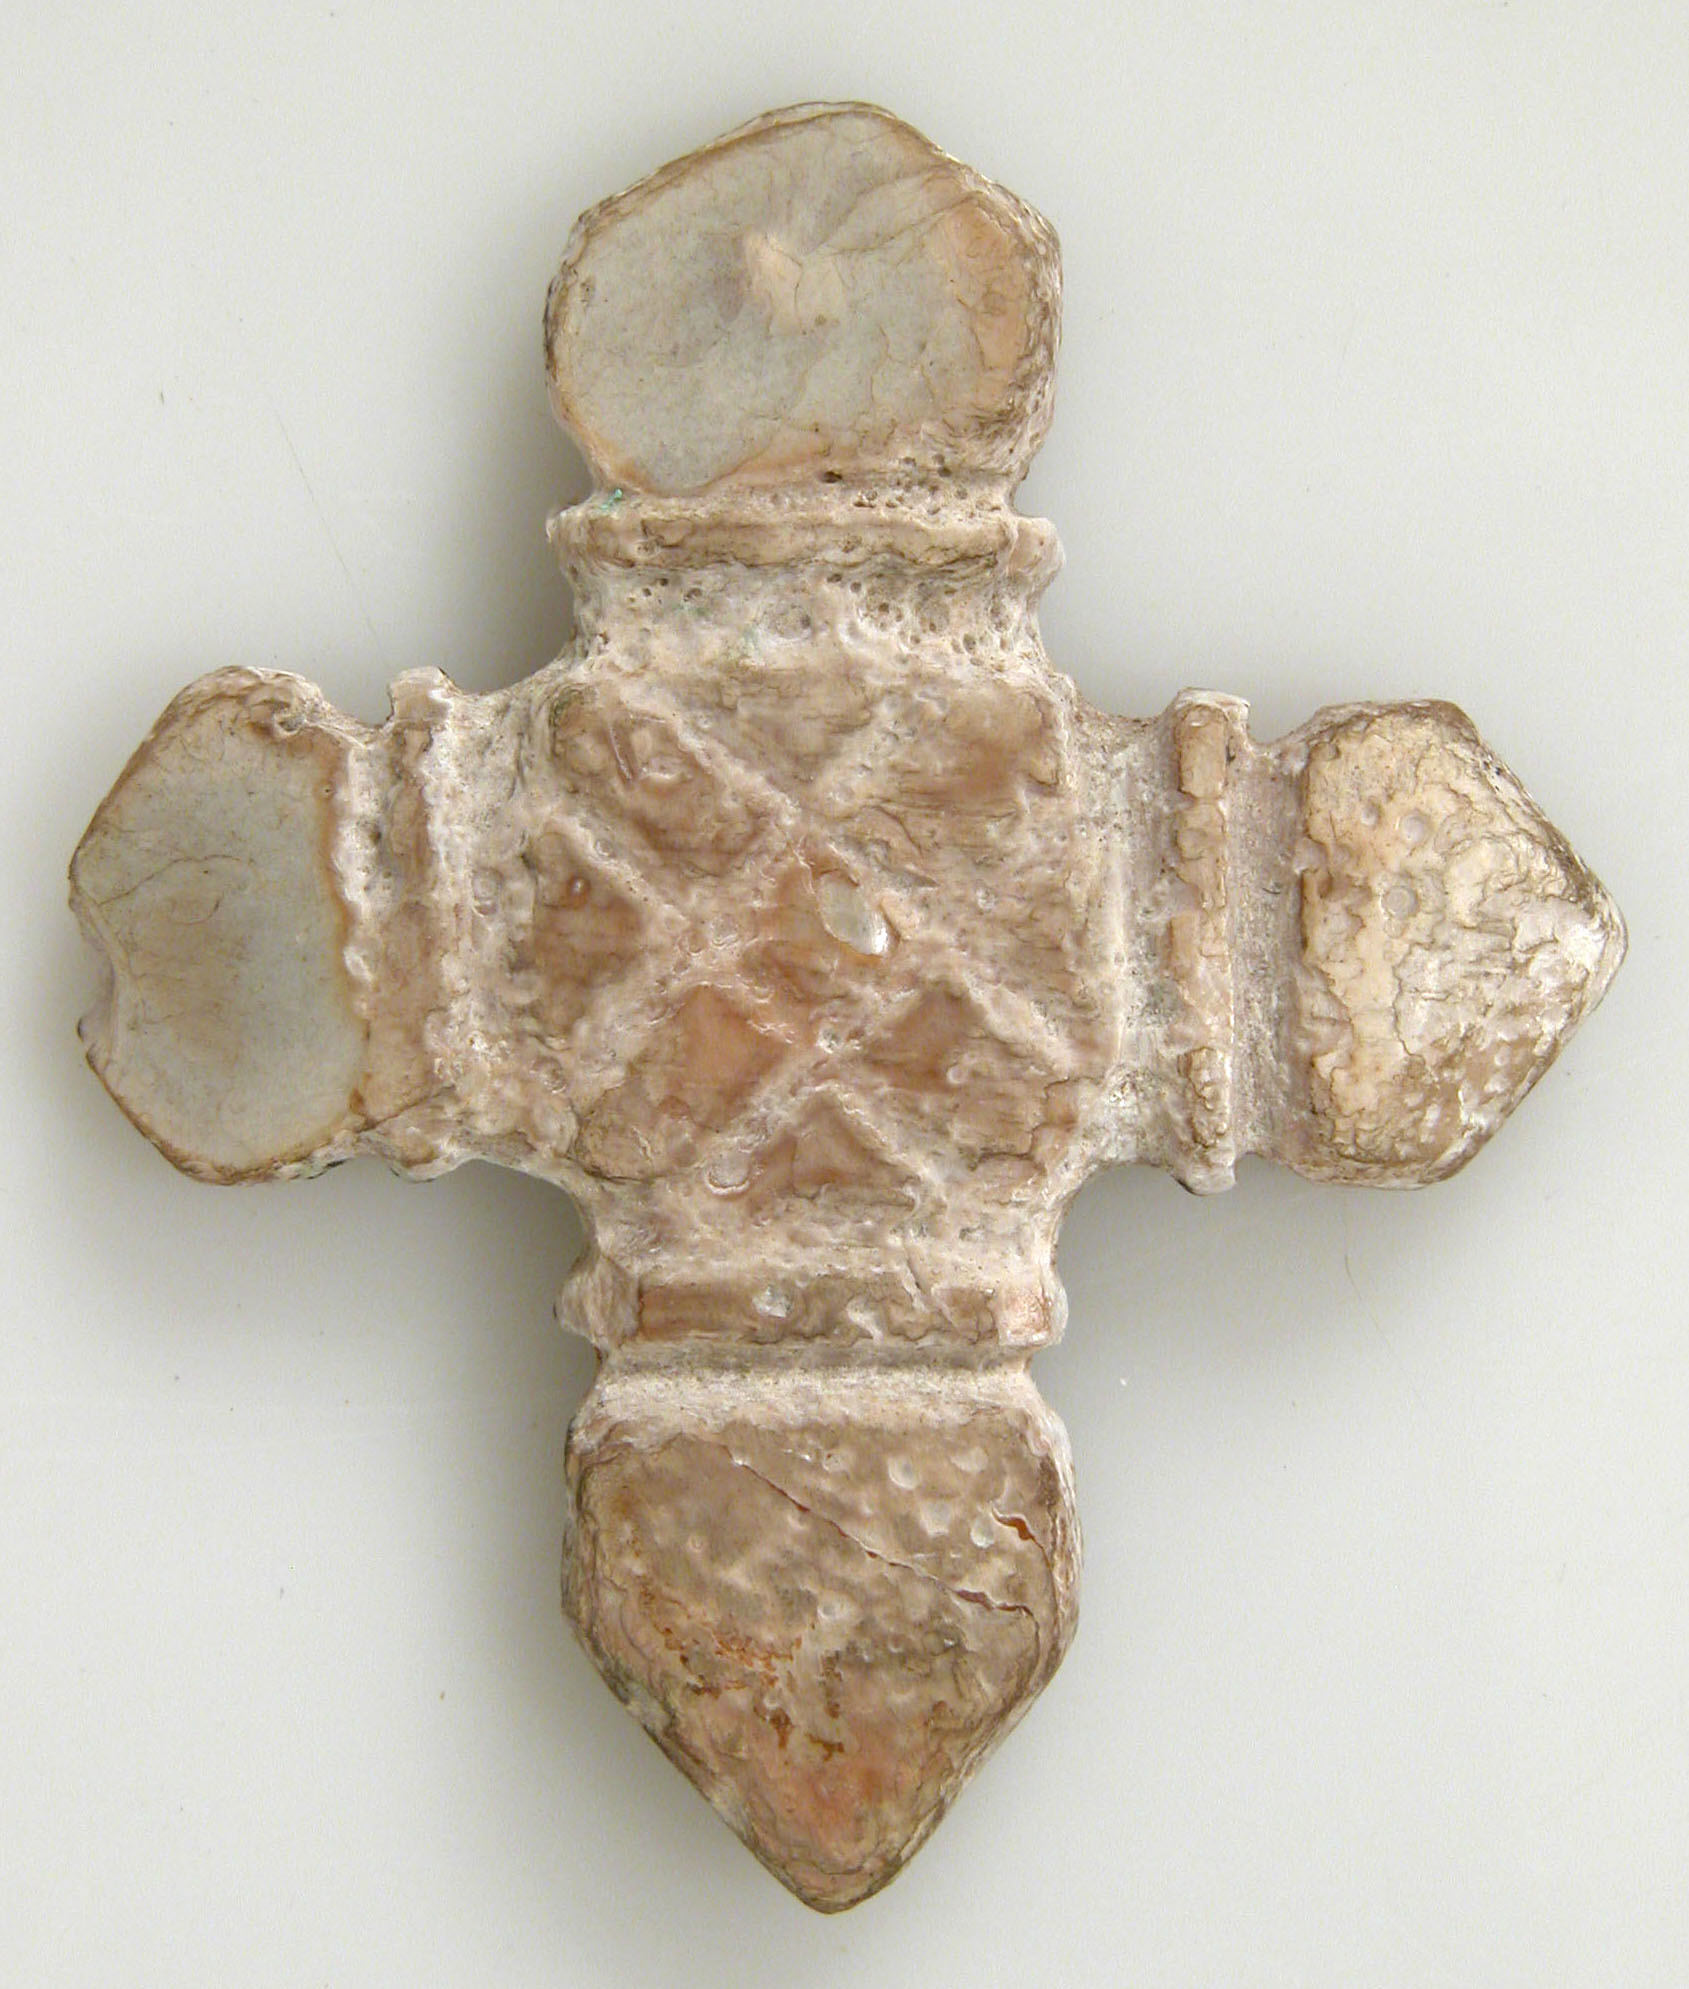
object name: cross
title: Shell Cross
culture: byzantine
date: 300-700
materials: shell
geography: northern france